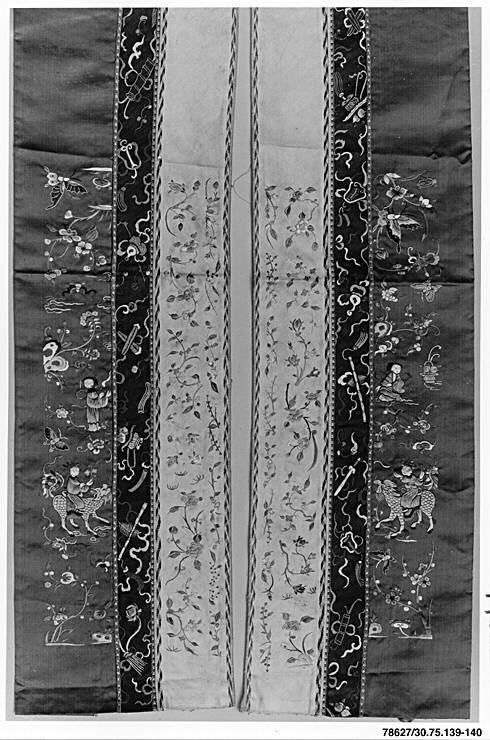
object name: sleeve band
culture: chinese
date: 1801-1900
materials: silk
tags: human figures,animals,butterflies,flowers